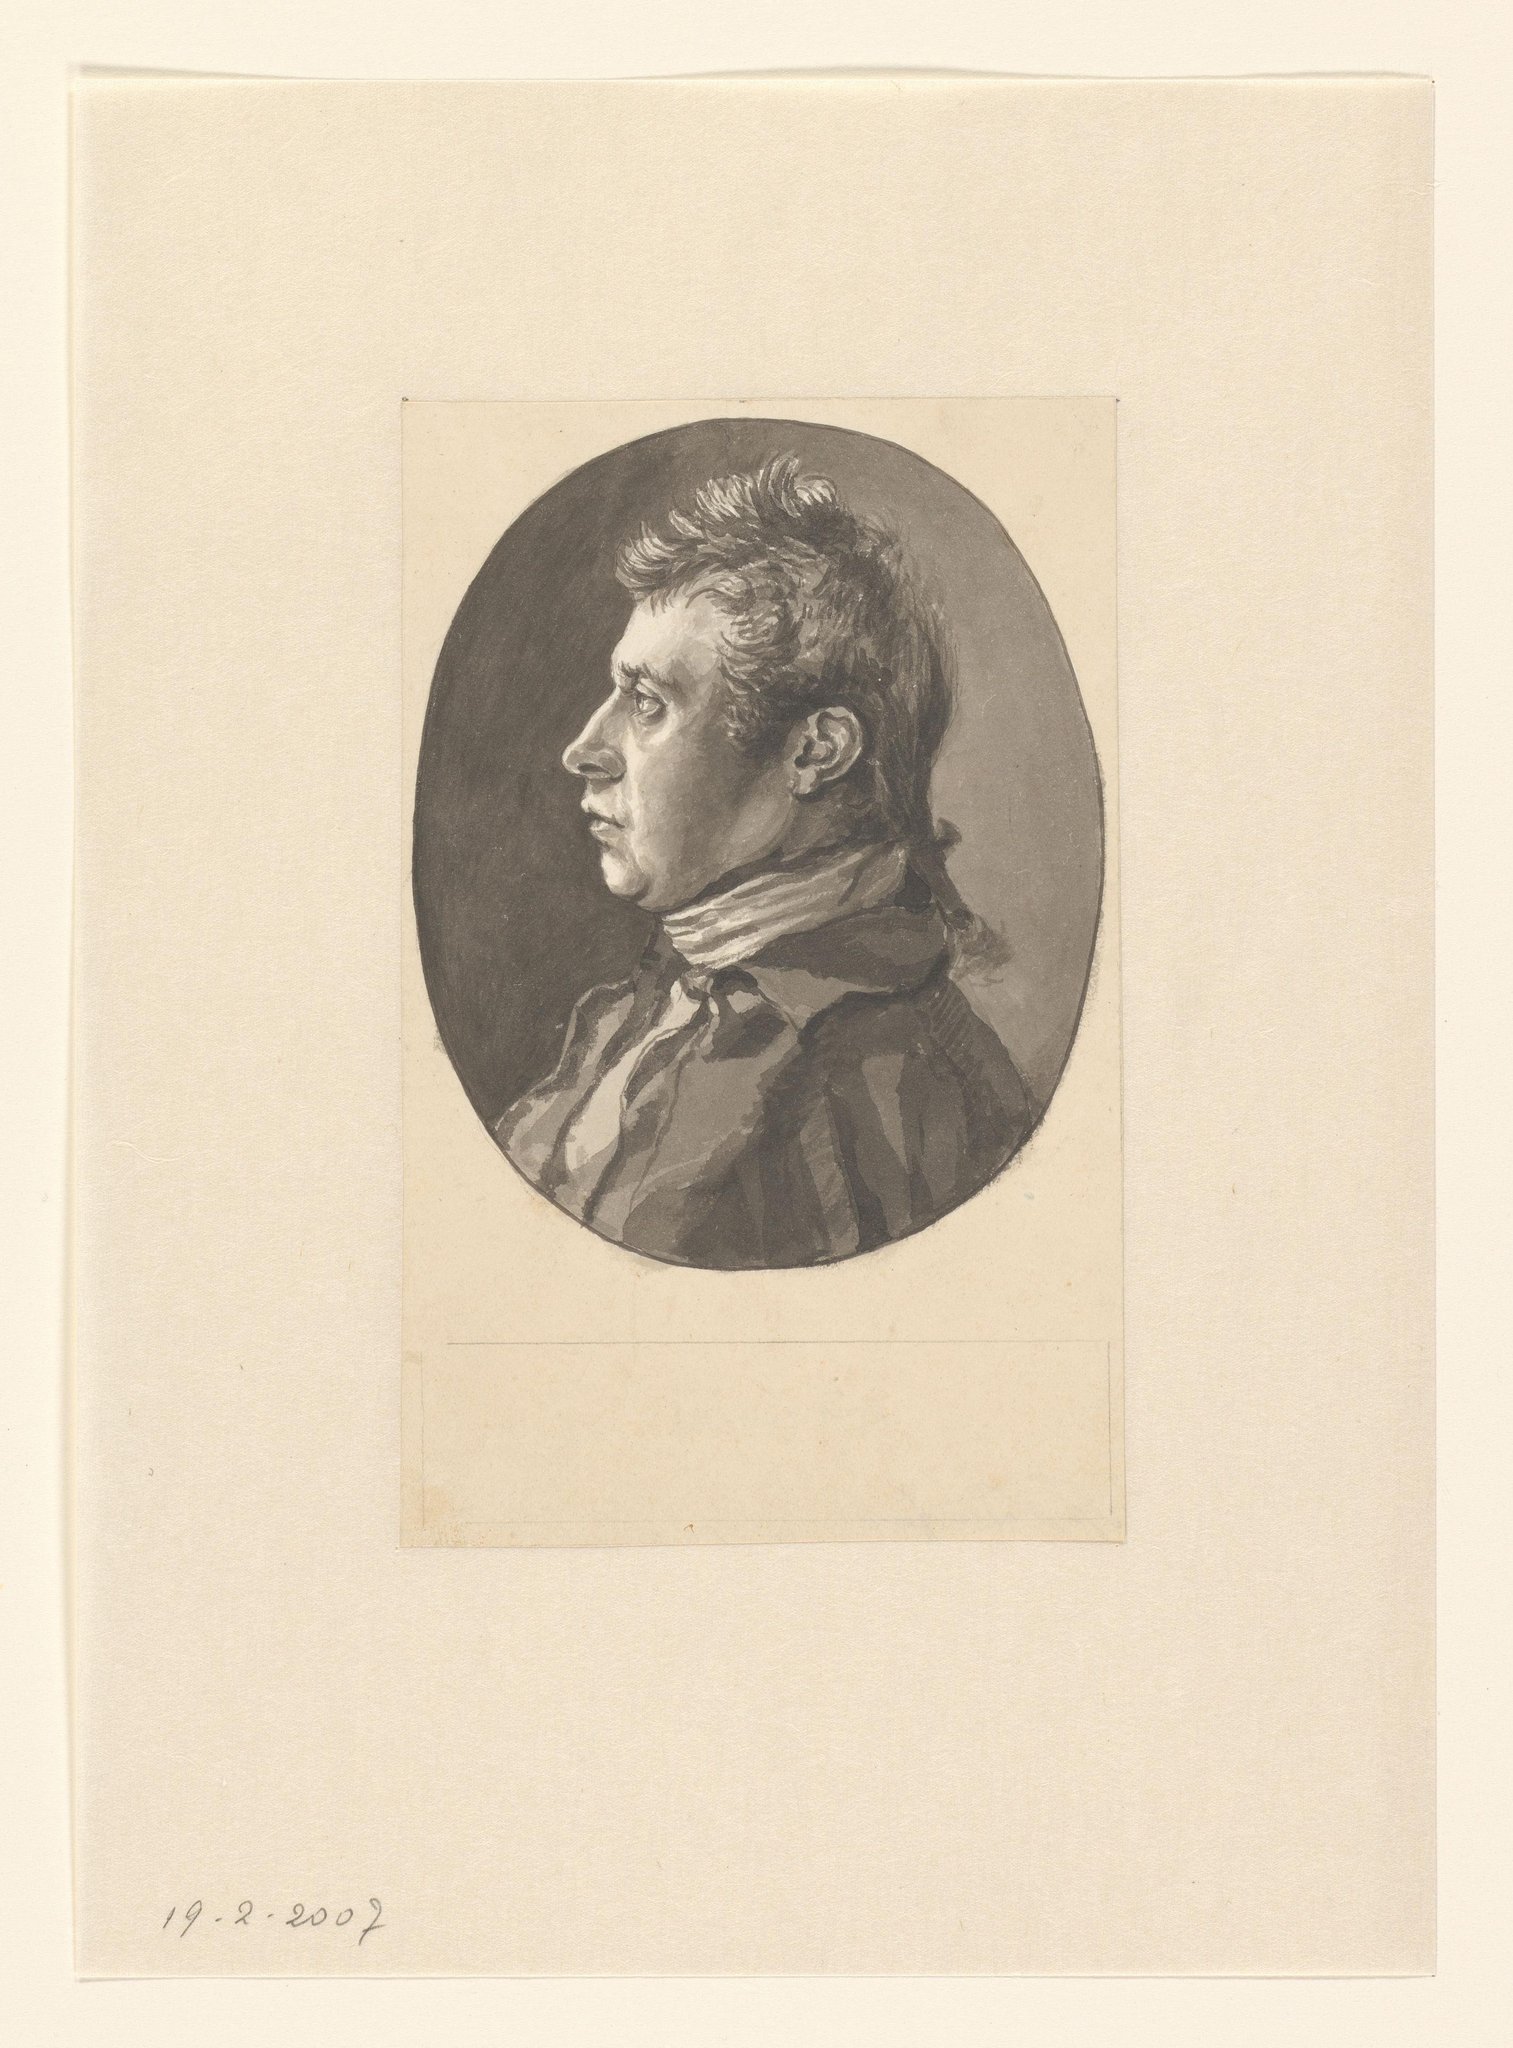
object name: drawing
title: Portret van Ernst Willem Jan Bagelaar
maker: willem joost lodewijk spoor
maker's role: draughtsman, print maker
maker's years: 1749-1821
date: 1795-1821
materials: ink, pencil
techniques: brush, pen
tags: print maker, draughtsman, ernst willem jan bagelaar, historical persons, portrait, self-portrait of artist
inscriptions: signature: ‘Spoor ad.viv. fecit’